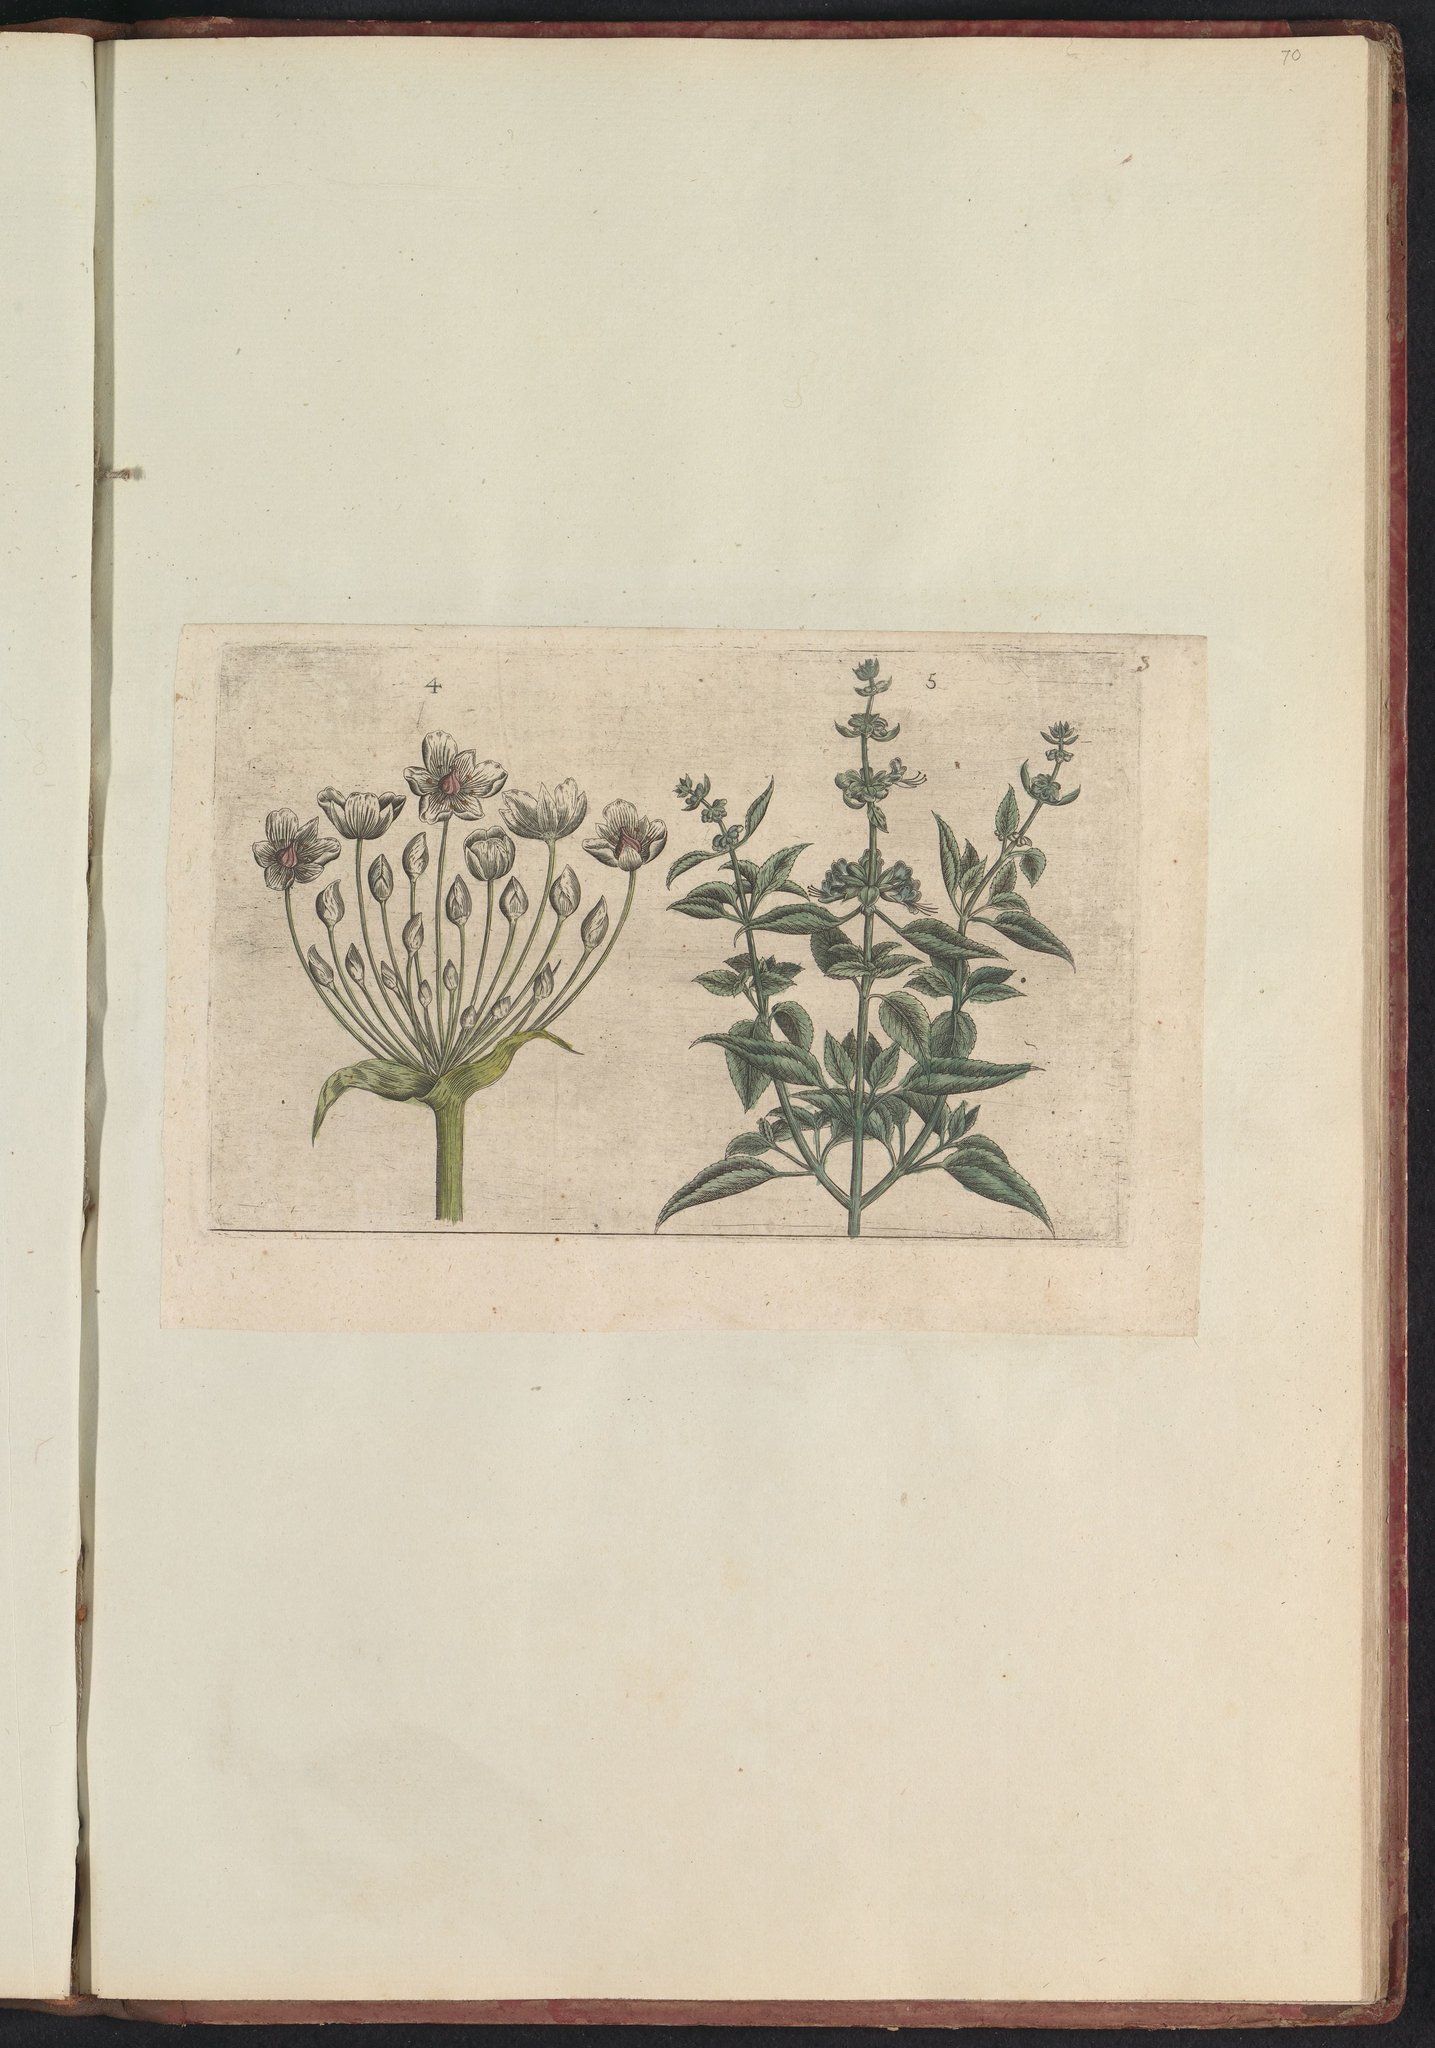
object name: print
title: Zwanenbloem (Butomus umbellatus) en kleinbloemige salie (Salvia verbenaca)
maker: Anonymous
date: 1604-1632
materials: ink, paper, watercolor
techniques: engraving, hand coloring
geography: southern netherlands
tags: flowers: flowering rush, flowers: sage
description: Zwanenbloem en kleinbloemige salie. Figs. 4 en 5 op een blad met de hand genummerd 3. In: Anselmi Boëtii de Boot I.C. Brugensis & Rodolphi II. Imp. Roman. medici a cubiculis Florum, Herbarum, ac fructuum selectiorum icones, & vires pleraeque hactenus ignotæ. Onderdeel van het album met bladen en platen uit De Boodts herbarium van 1640. Het twaalfde van twaalf albums met aquarellen van dieren, vogels en planten bekend rond 1600, gemaakt in opdracht van keizer Rudolf II.